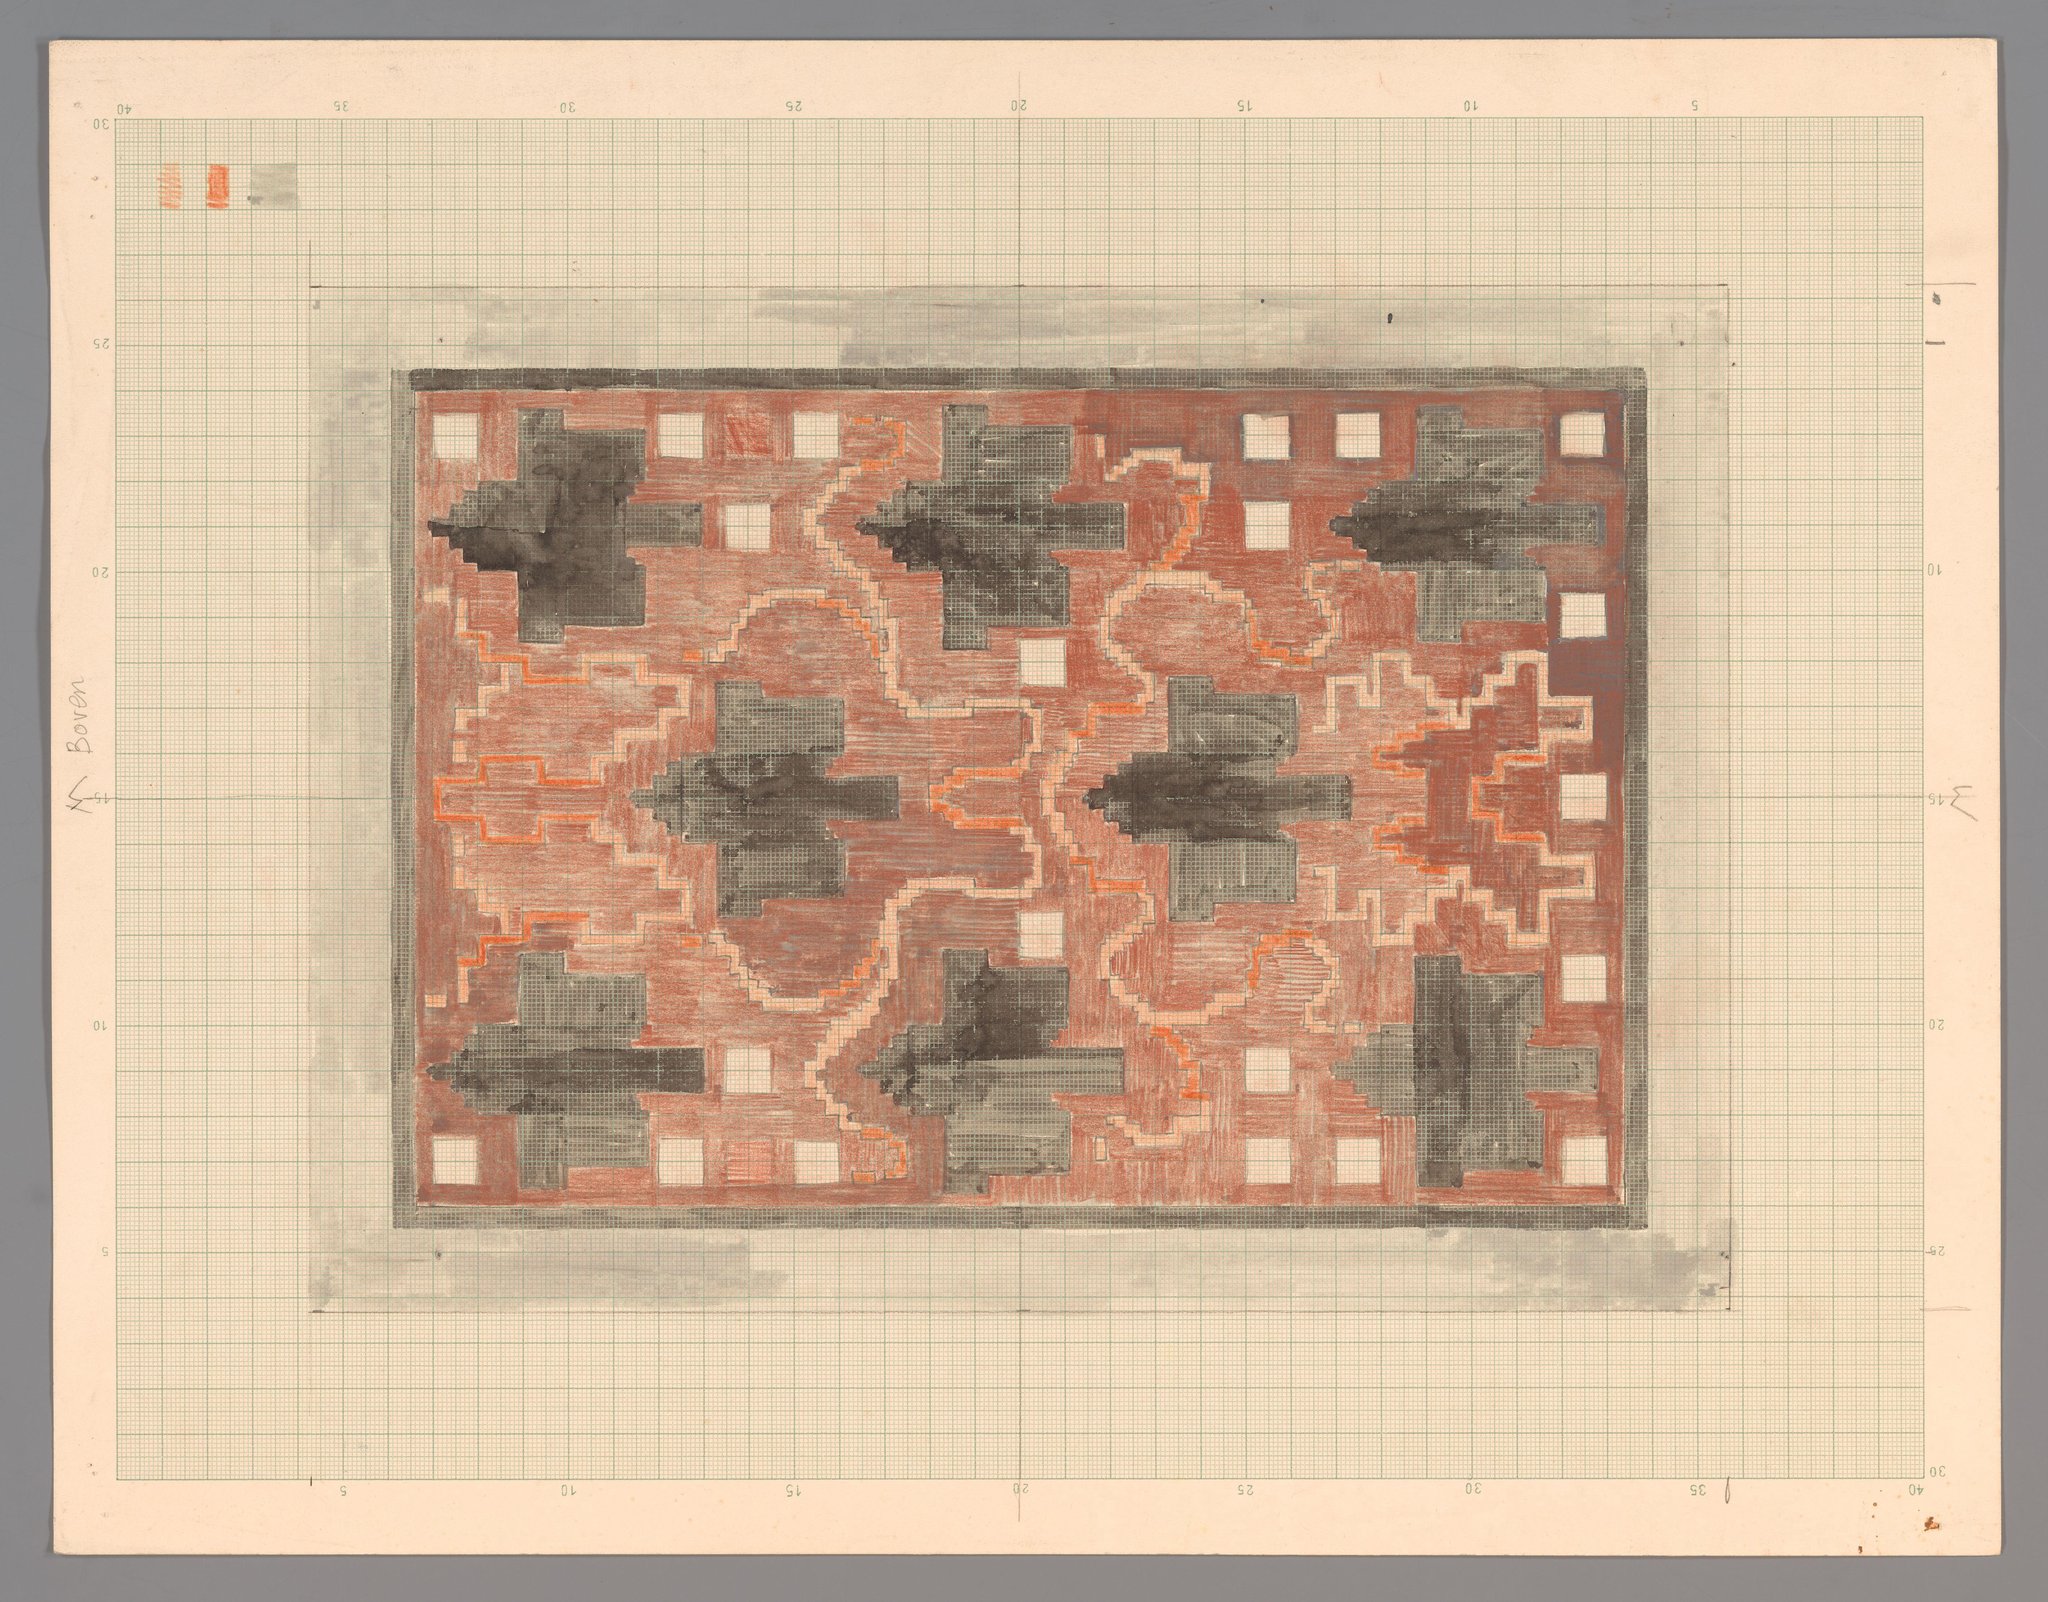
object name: design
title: Decoratief ontwerp in rood en zwart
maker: carel adolph lion cachet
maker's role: draughtsman, print maker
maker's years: 1864-1945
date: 1874-1945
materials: pencil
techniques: brush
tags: carpet, rug